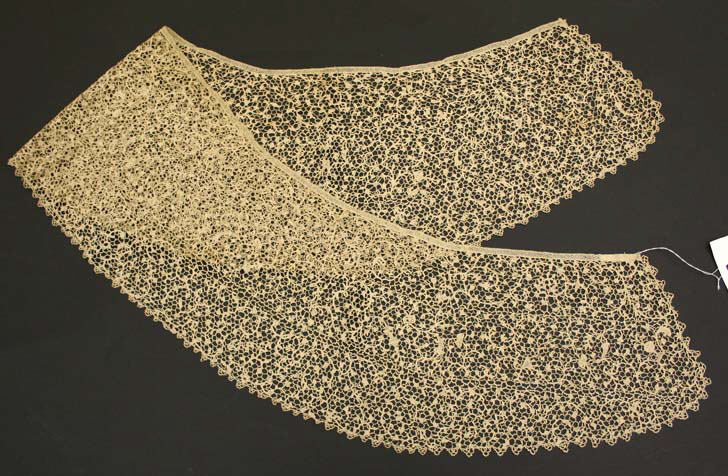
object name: bertha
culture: italian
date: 1675-1725